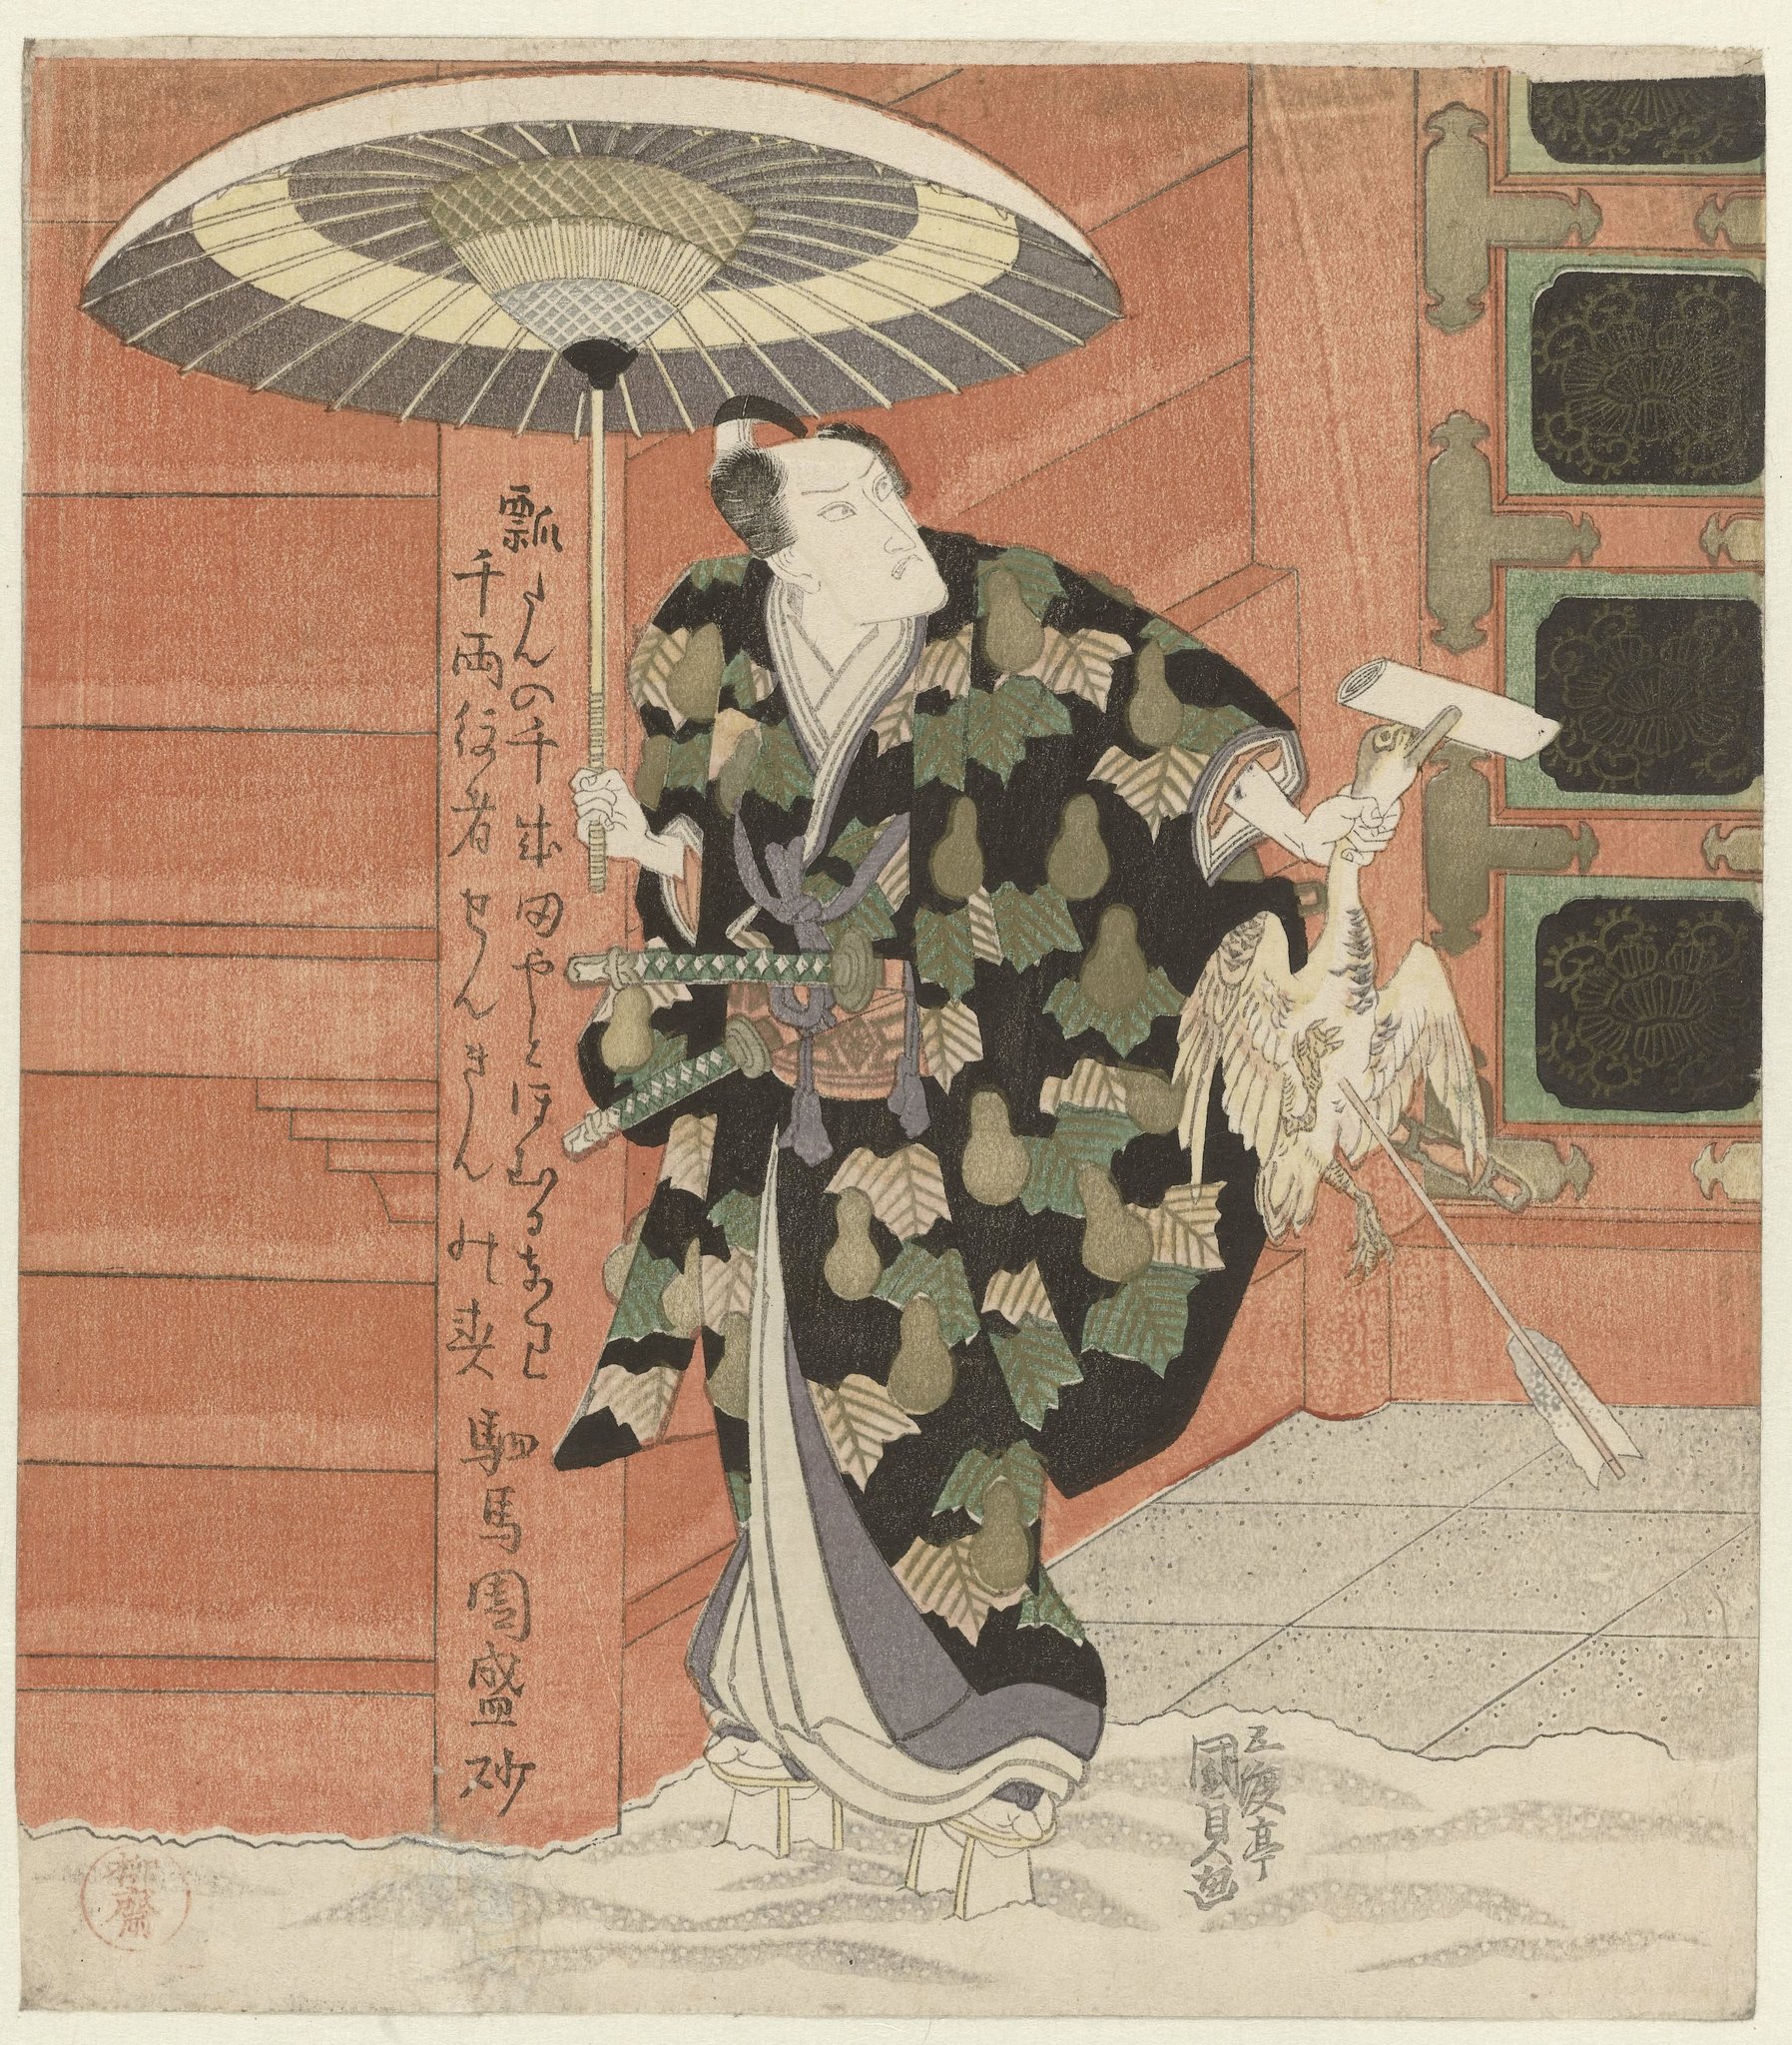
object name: surimono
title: Acteur met een gans in de hand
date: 1820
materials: paper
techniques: woodcut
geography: japan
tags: water-birds: goose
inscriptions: collector's mark, passe-partout, bottom left, printed: JABdH with a rooster., collector's mark, verso, stamped: Lugt 2228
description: Acteur Ichikawa Danjûrô (1791-1859) in de rol van Konoshita Tôkichi staat voor een poort, met een paraplu en een met pijl doorboorde gans in de hand. Deze prent is het linkerblad van een diptiek dat deel uit maakt van een piramide-vormig triptiek; het rechter blad en het blad wat schuin boven het huidge blad hoort, ontbreken. Met één gedicht op de pilaar: 'Geprezen als de 'duizend kalebassen' van Naritaya, wederom een succesvol seizoen wacht op deze acteur van de eerste rang' Naritaya was een van de namen die Ichikawa Danjûrô gebruikte bij het schrijven van gedichten.